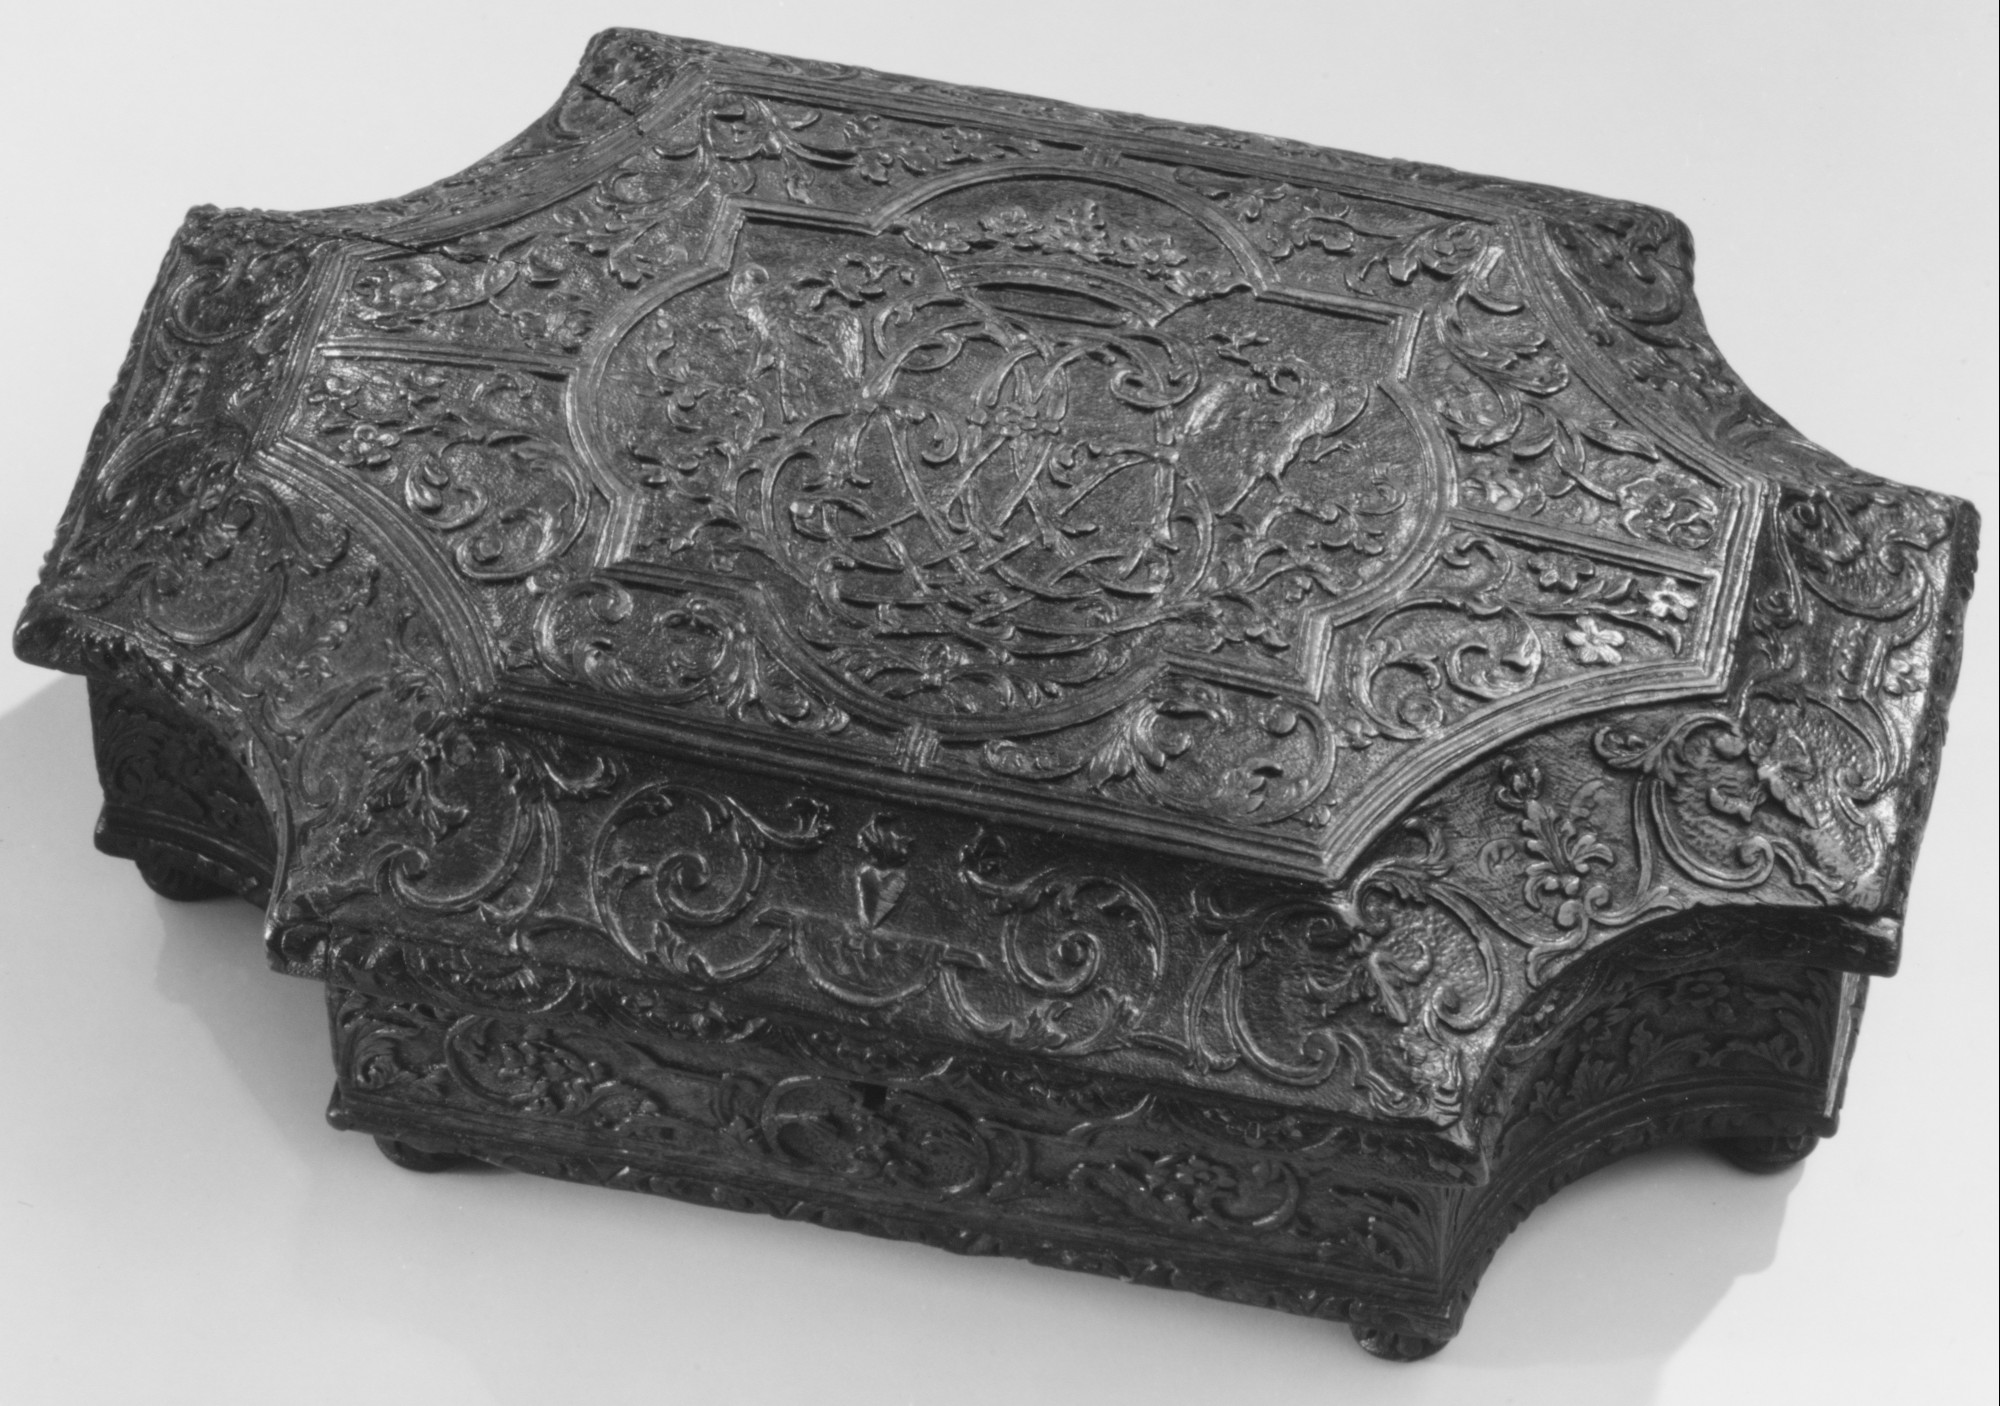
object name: box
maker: nicolas françois foulon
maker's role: maker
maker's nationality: french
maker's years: 1628-1698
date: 1667-1733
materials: wood